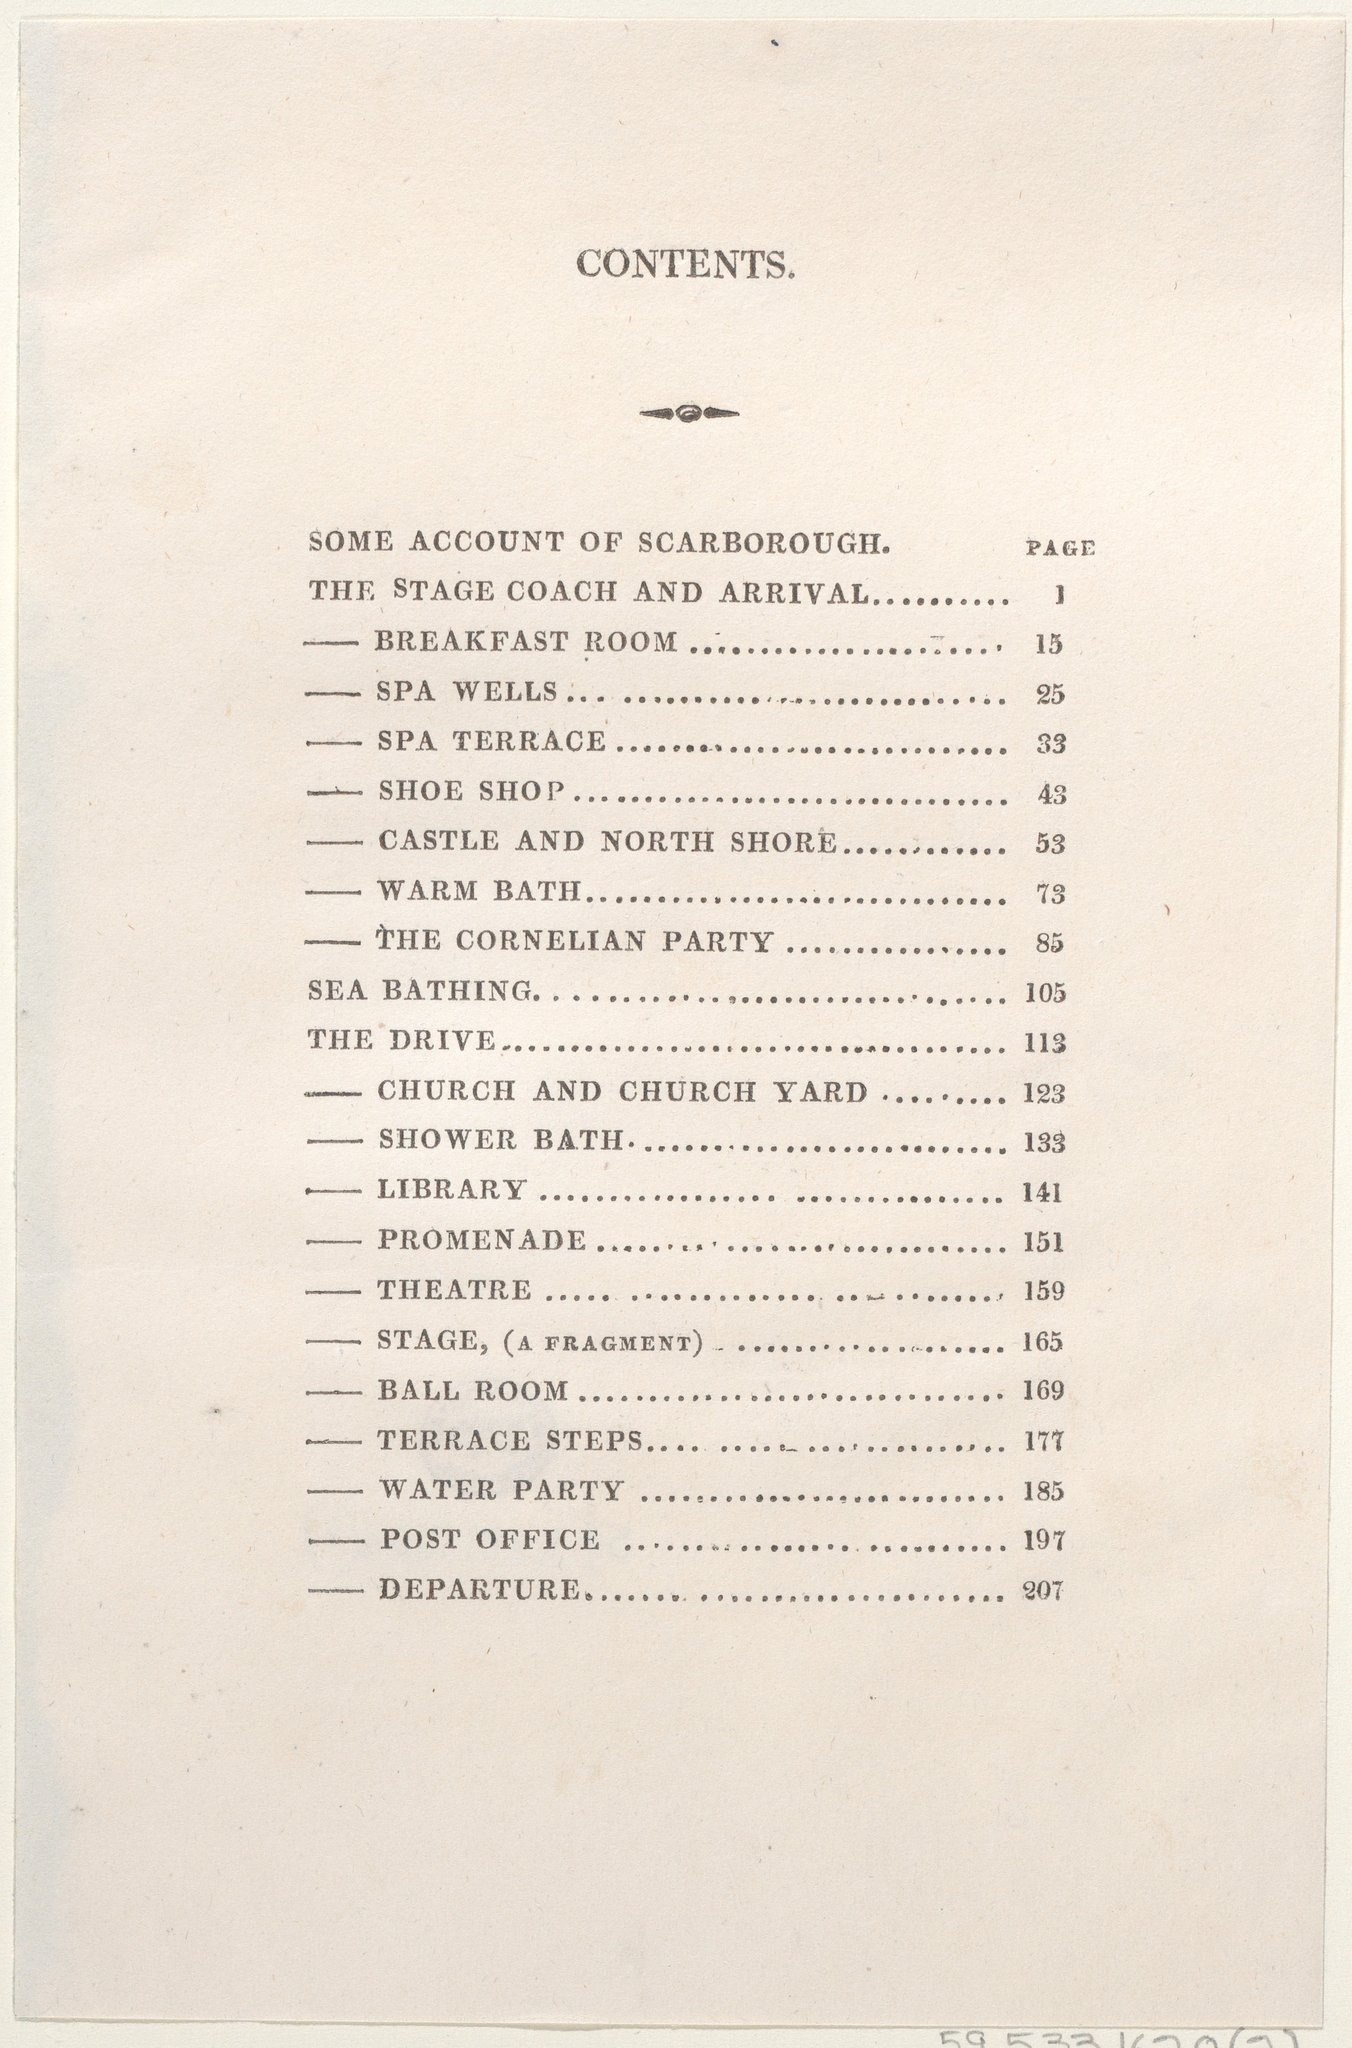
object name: print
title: Table of Contents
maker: thomas rowlandson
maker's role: artist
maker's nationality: british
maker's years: 1757-1827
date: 1813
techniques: letterpress